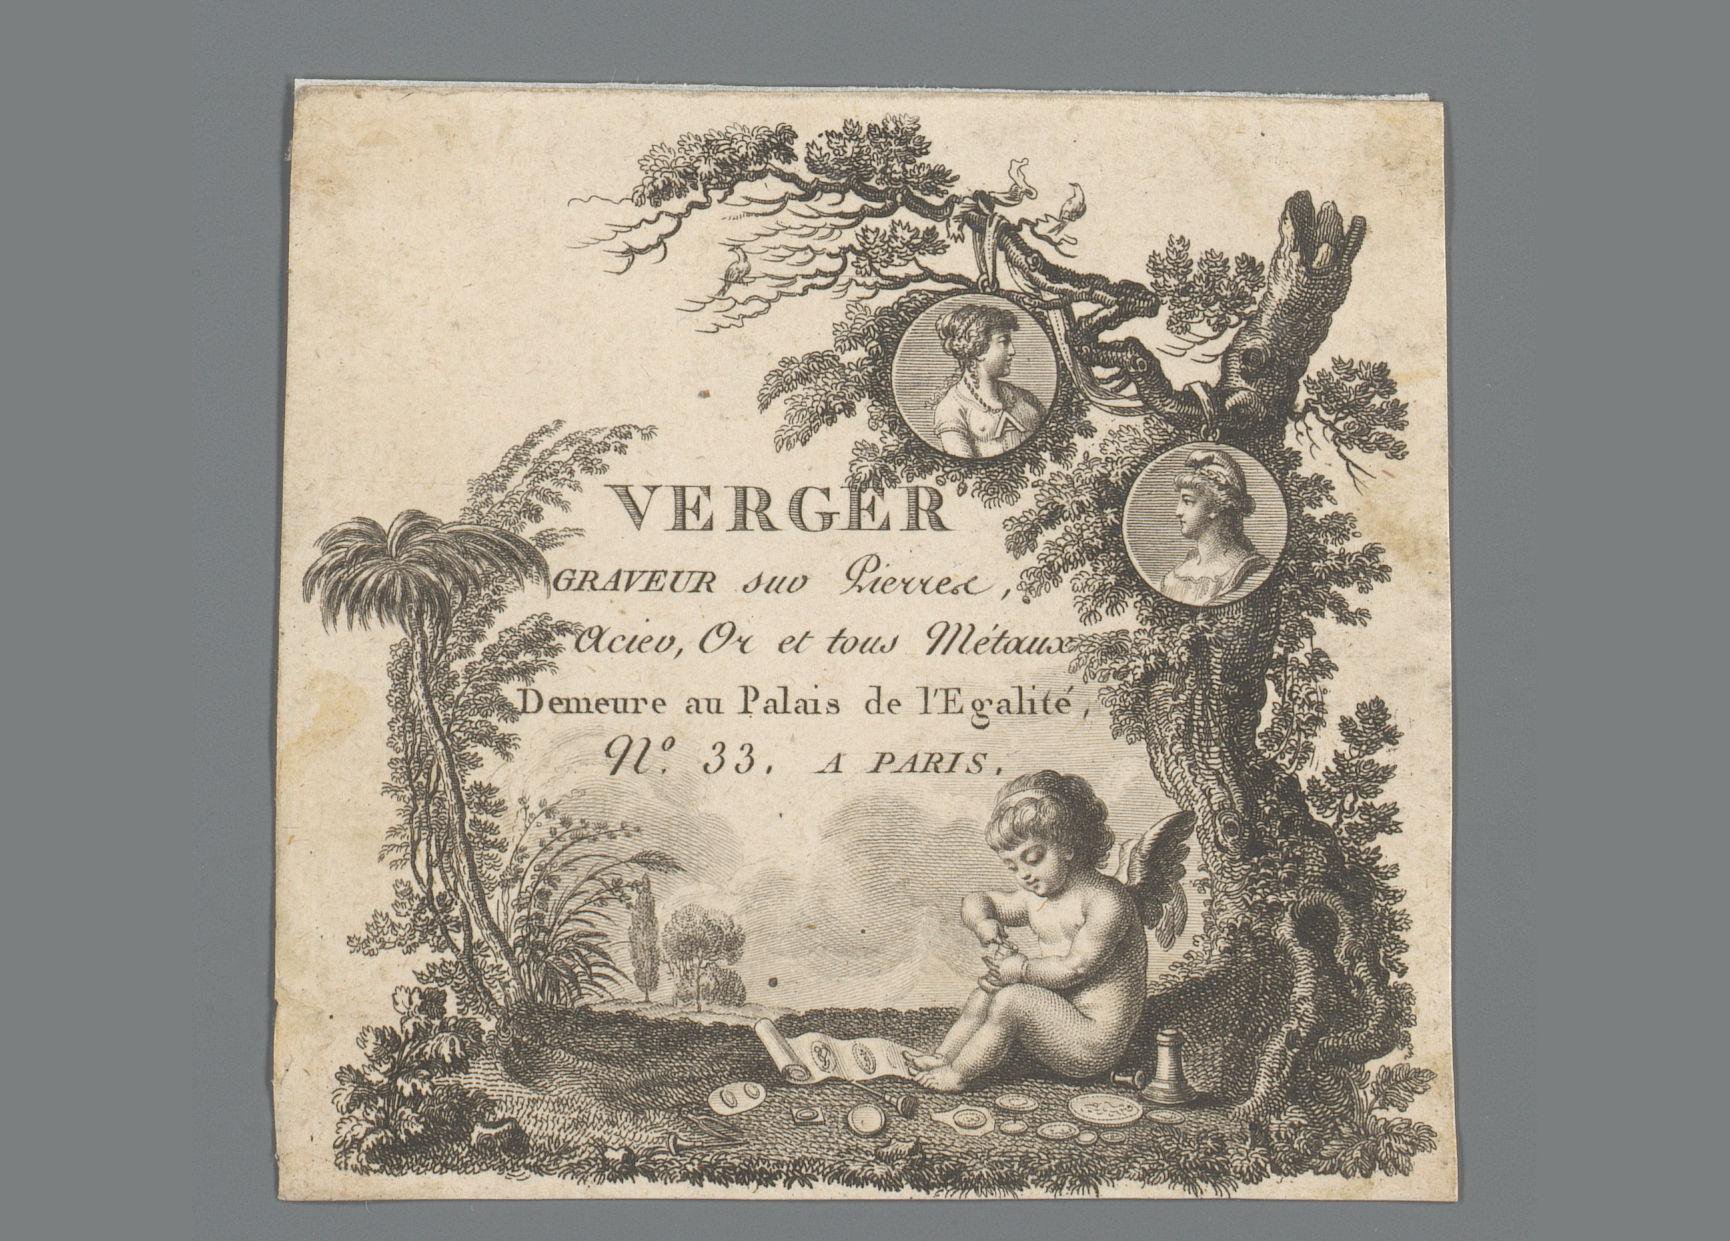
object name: business card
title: Adreskaart van metaal - en steengraveur Verger te Parijs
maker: Anonymous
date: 1700-1799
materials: paper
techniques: etching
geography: paris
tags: ornament ~ medallion, tools, implements of craftsman, ornamenting, decorating ~ applied arts, cupids: 'amores', 'amoretti', 'putti'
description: Zittende putto onder een boom, omringd door graveerinstrumenten.